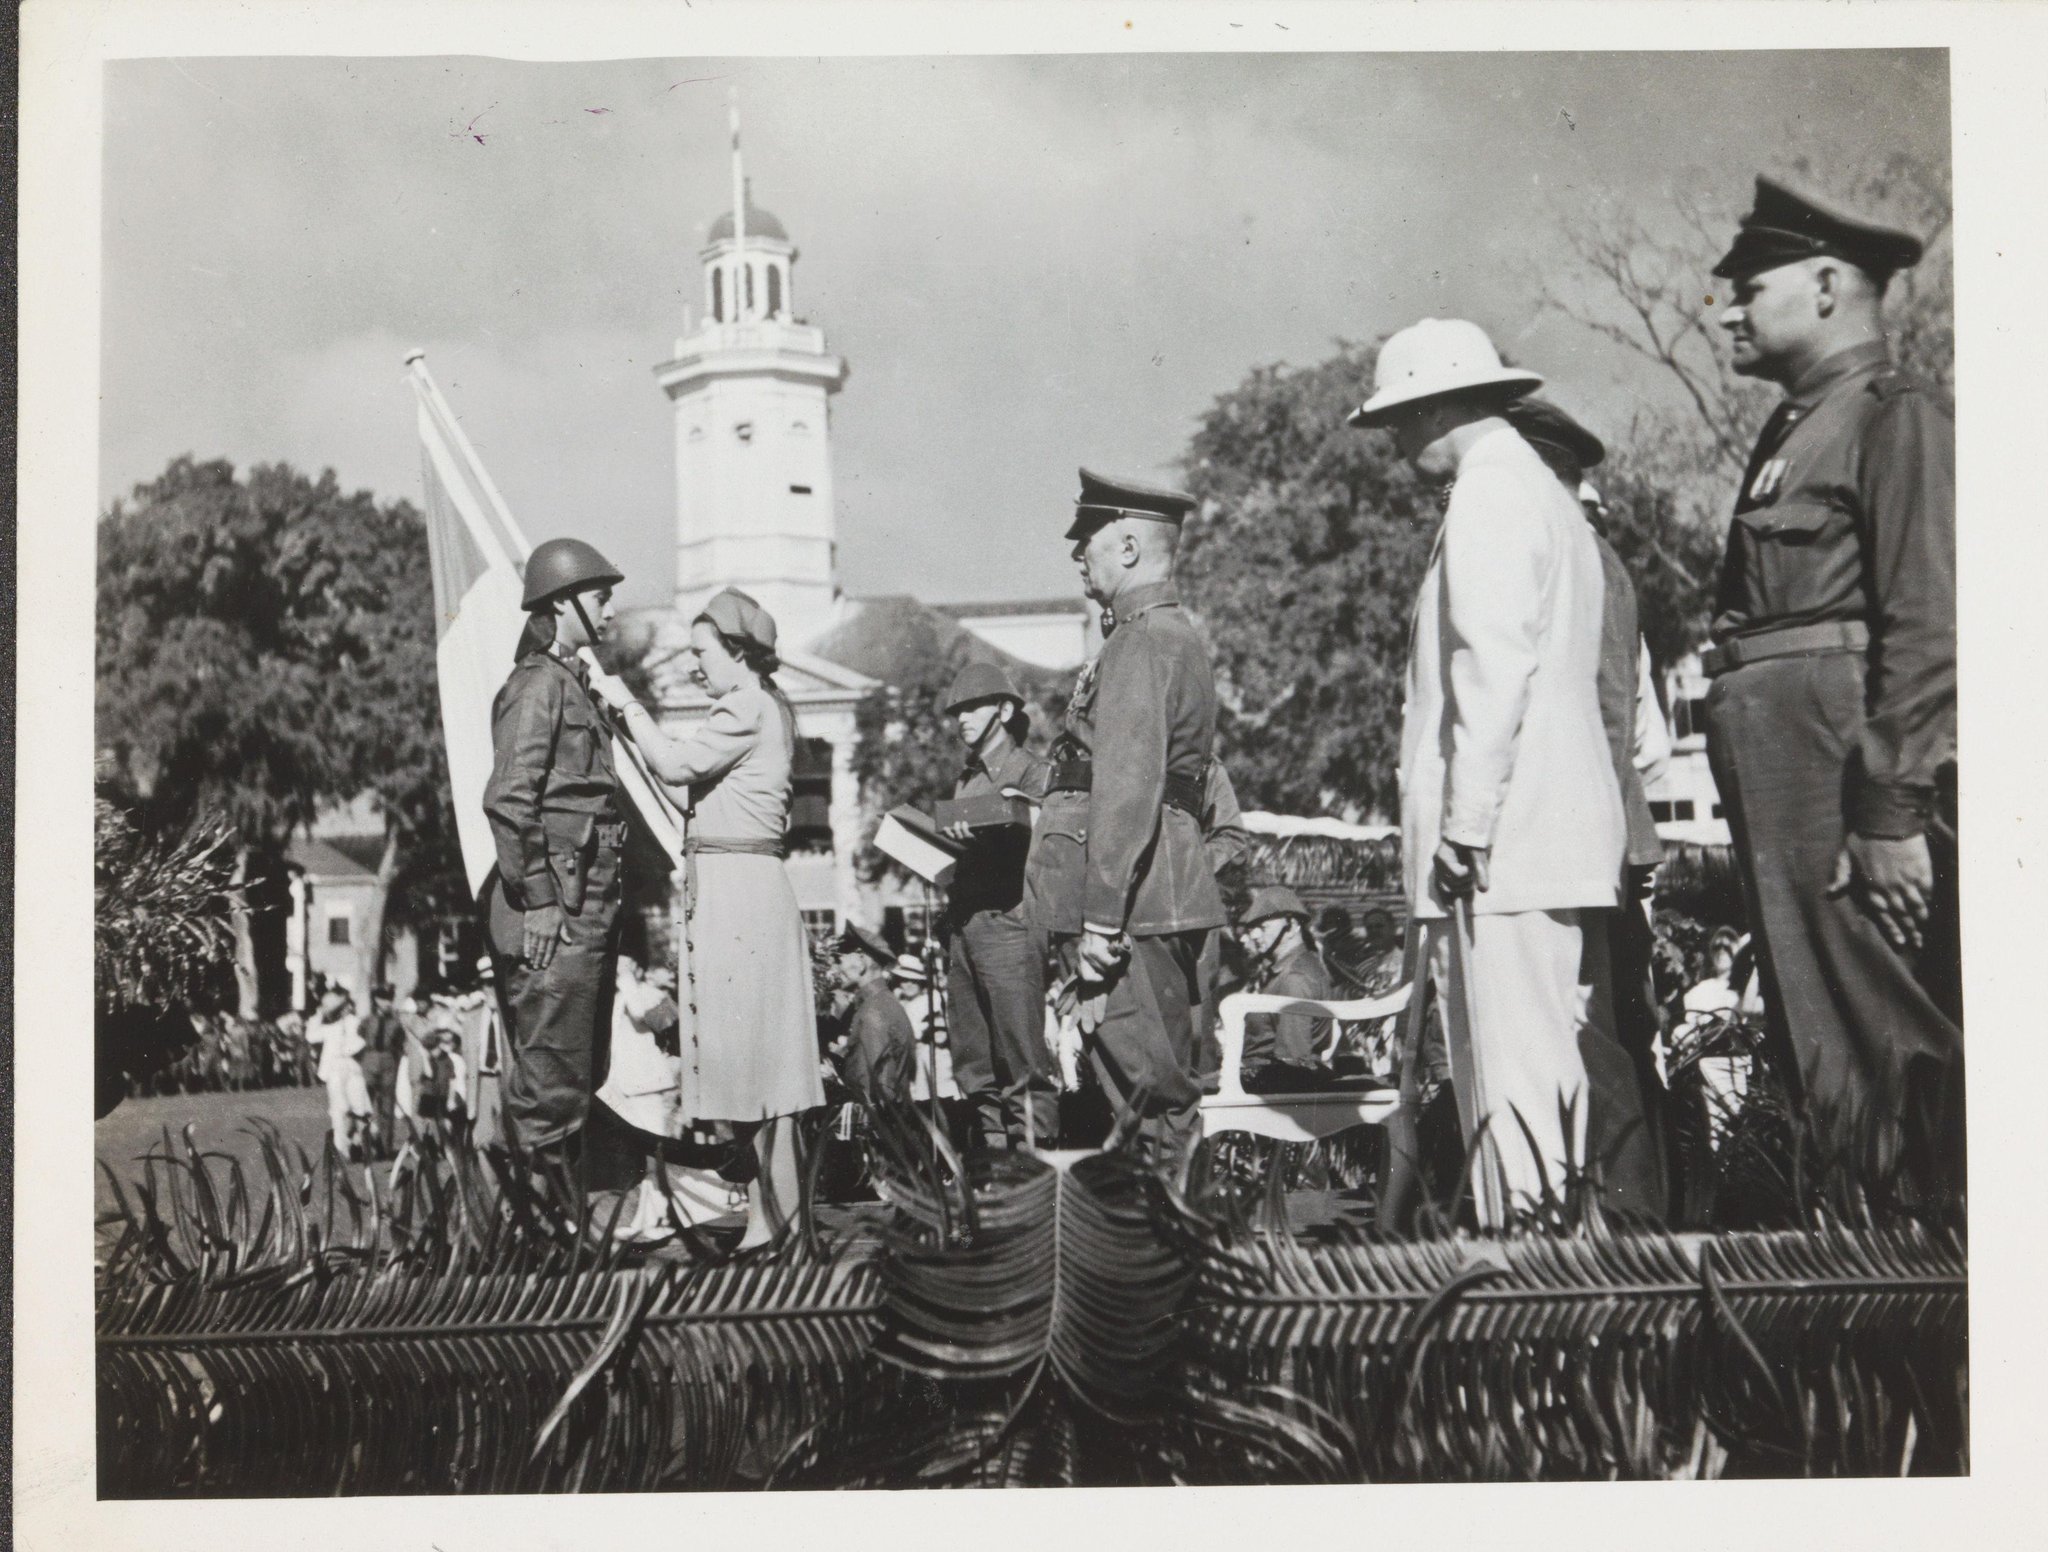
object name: photograph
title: Koningin Juliana speldt een onderscheiding op bij een militair op het Gouvernementsplein in Suriname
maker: Anonymous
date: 1945-1950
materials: photographic support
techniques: gelatin silver print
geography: netherlands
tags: juliana of the netherlands, queen, medals and other marks of military honour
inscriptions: signature: ‘Copyright Netherlands Government information bureau ...’, annotation: ‘Princess Juliana's visit to Surinam... when her country was overrun by the Germans. H.R.H. decorating a Dutch Lieutenant’